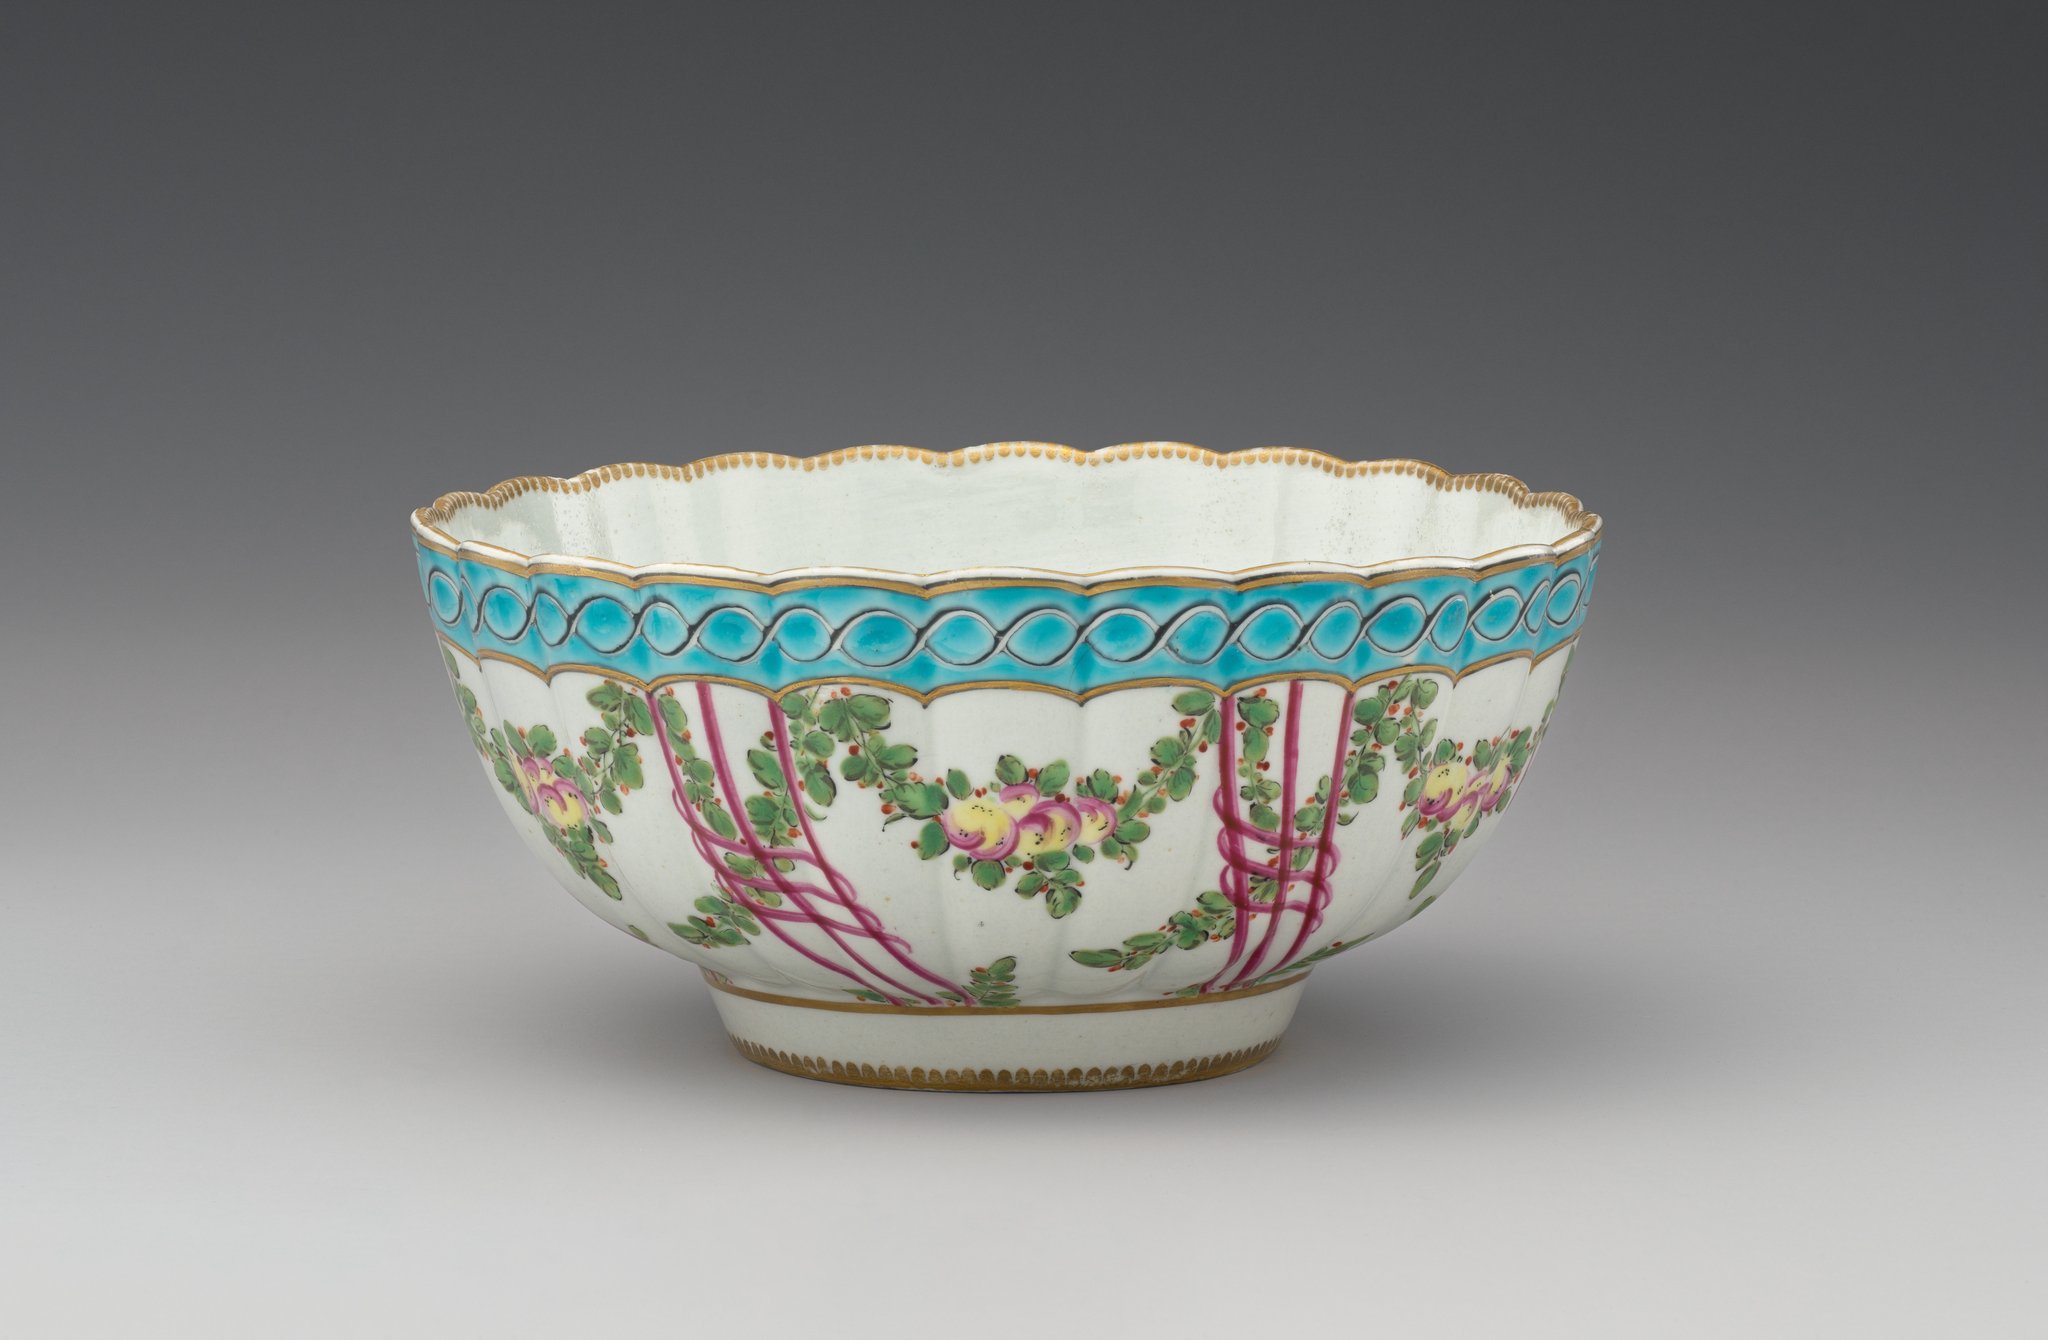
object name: waste bowl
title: Waste bowl (part of a service)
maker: worcester factory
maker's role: factory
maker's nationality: british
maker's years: 1751-2008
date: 1770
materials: soft paste porcelain